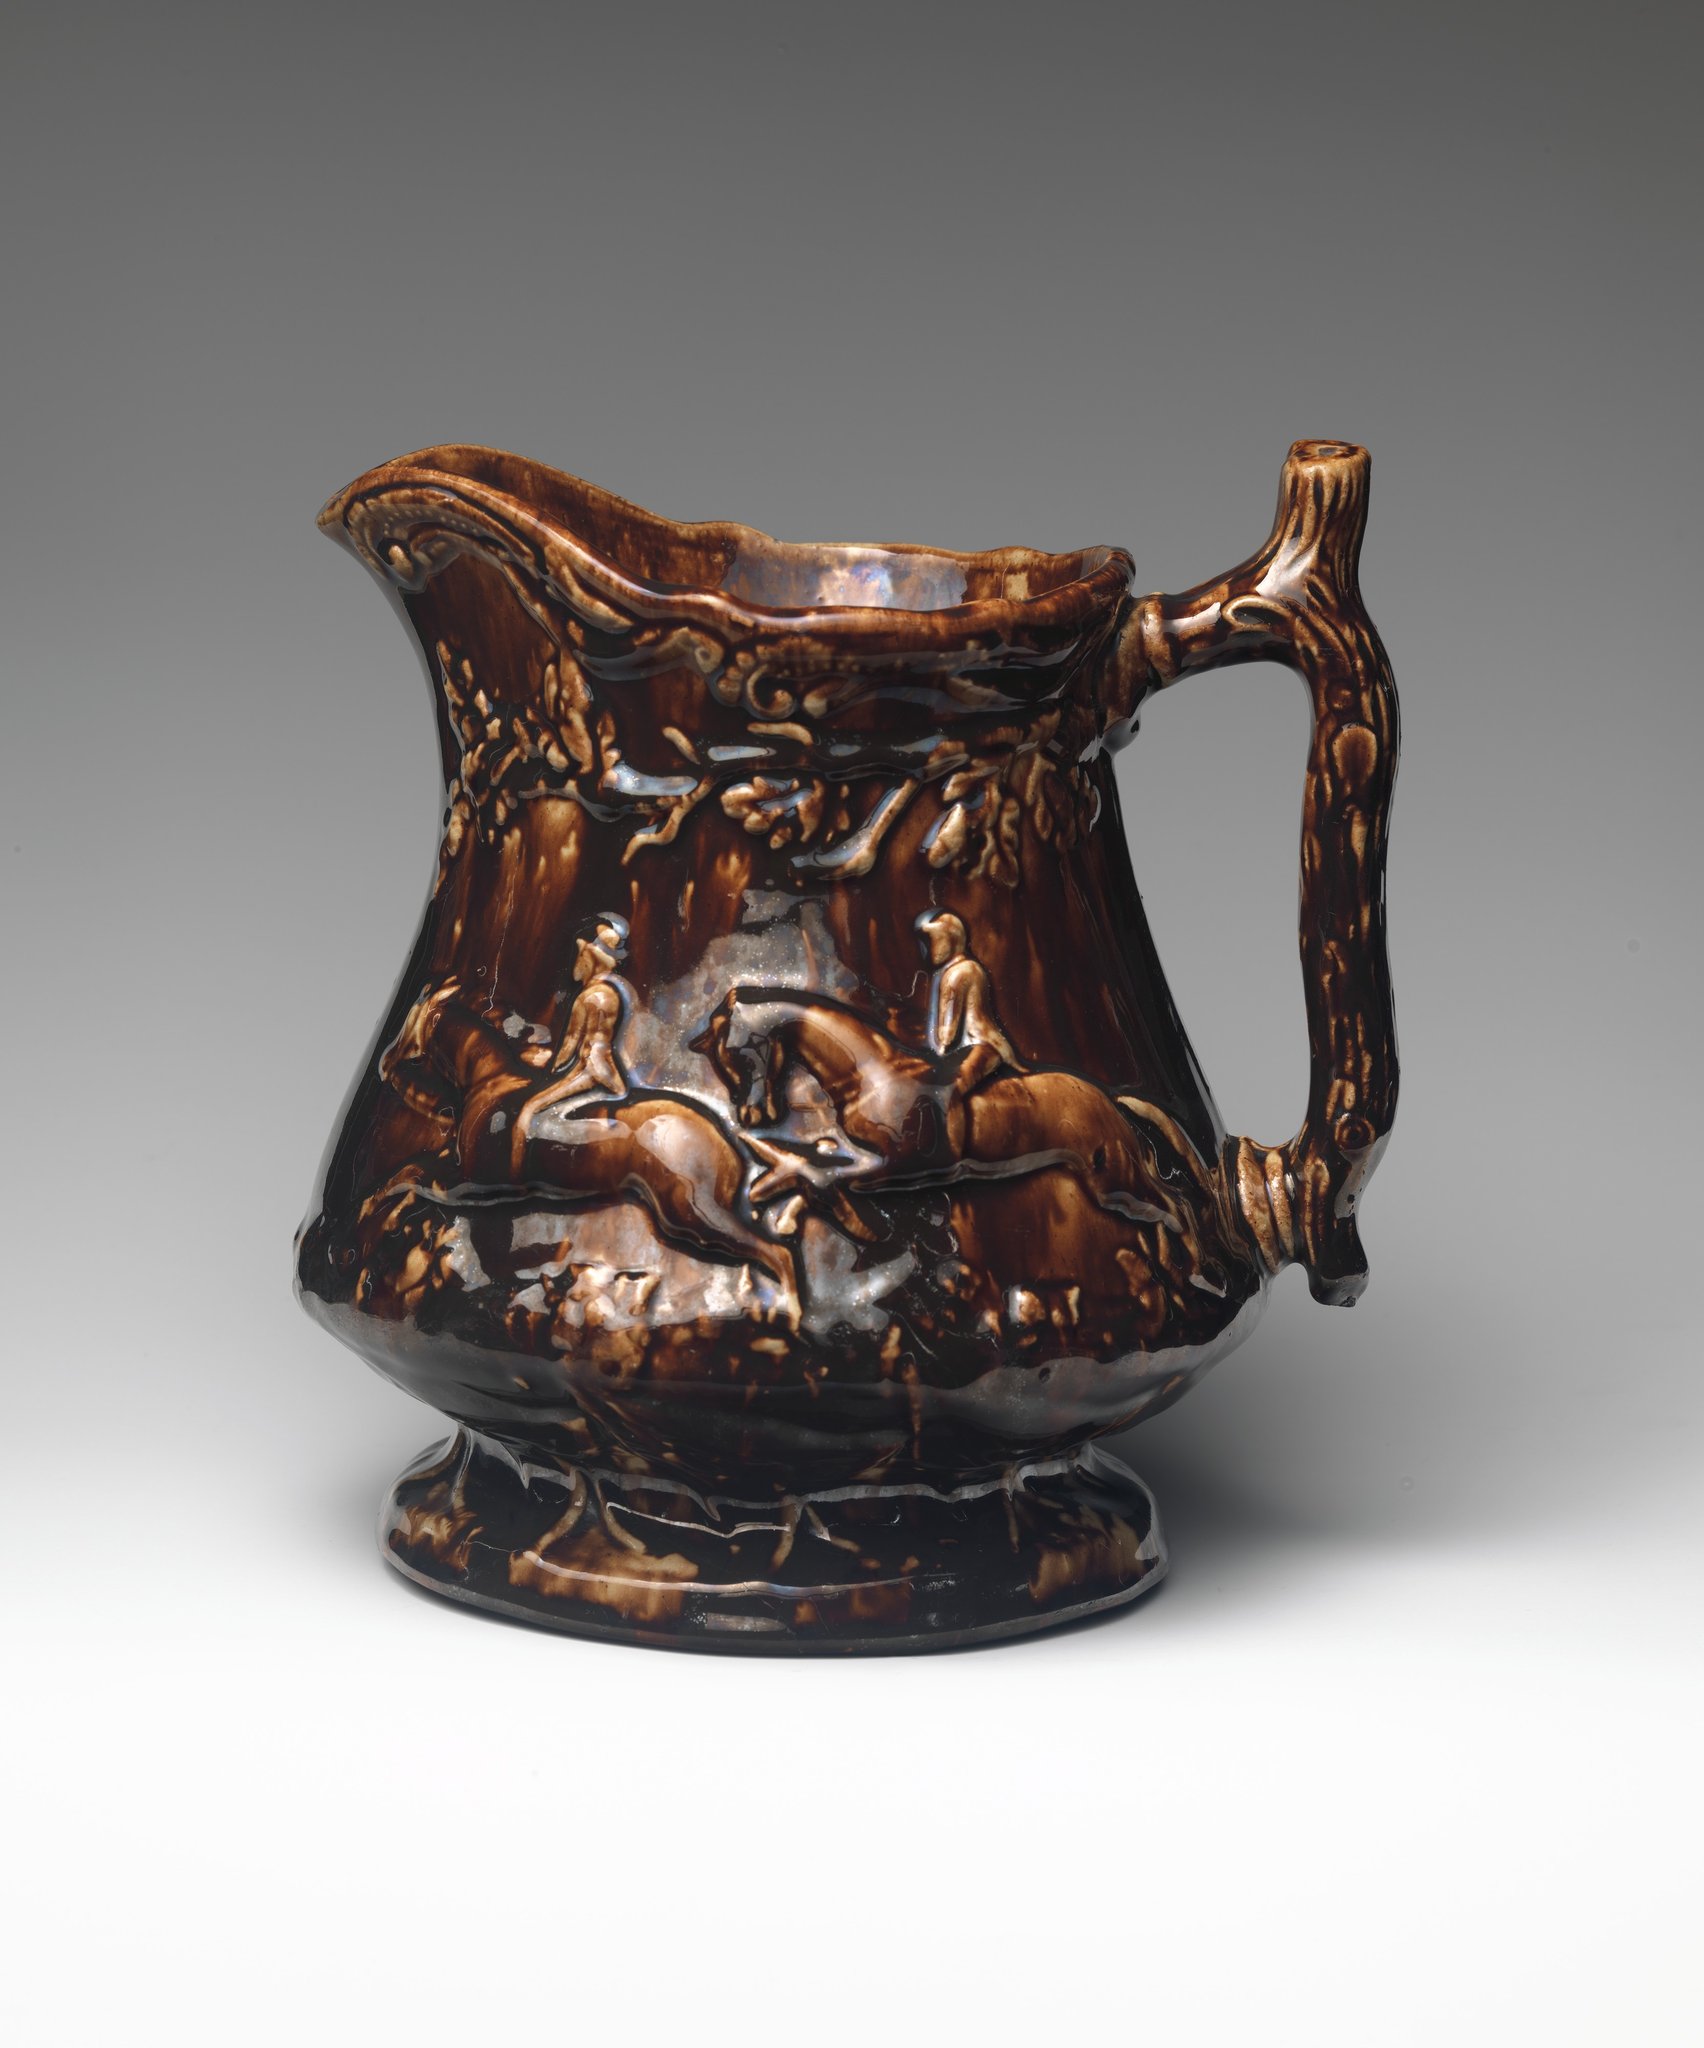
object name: pitcher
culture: american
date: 1830-1870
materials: earthenware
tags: hunting,dogs,horses